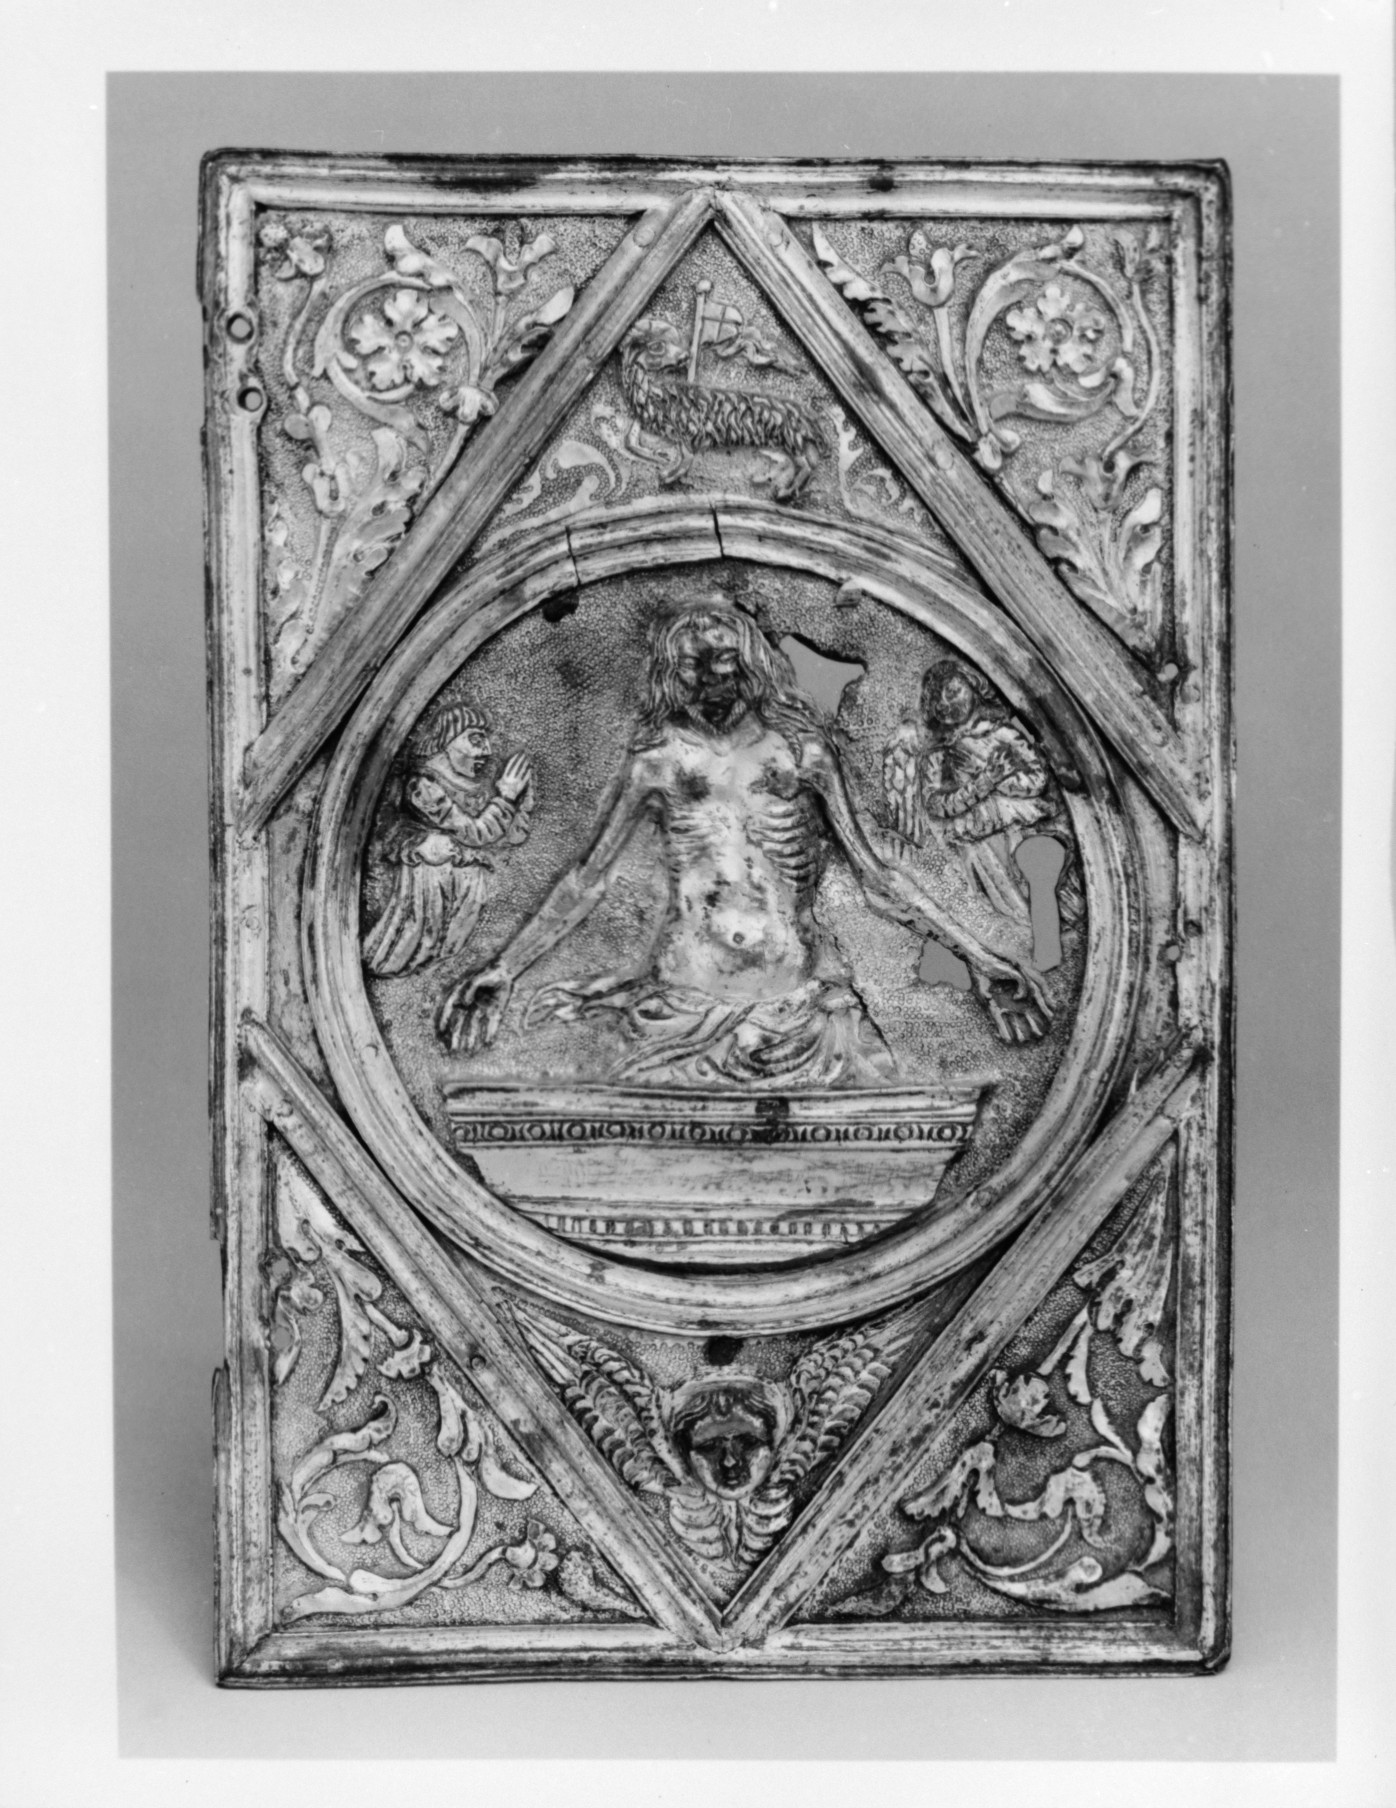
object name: pax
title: Dead Christ Between Two Angels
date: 1475-1490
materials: copper gilt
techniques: repoussé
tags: flowers,angels,christ